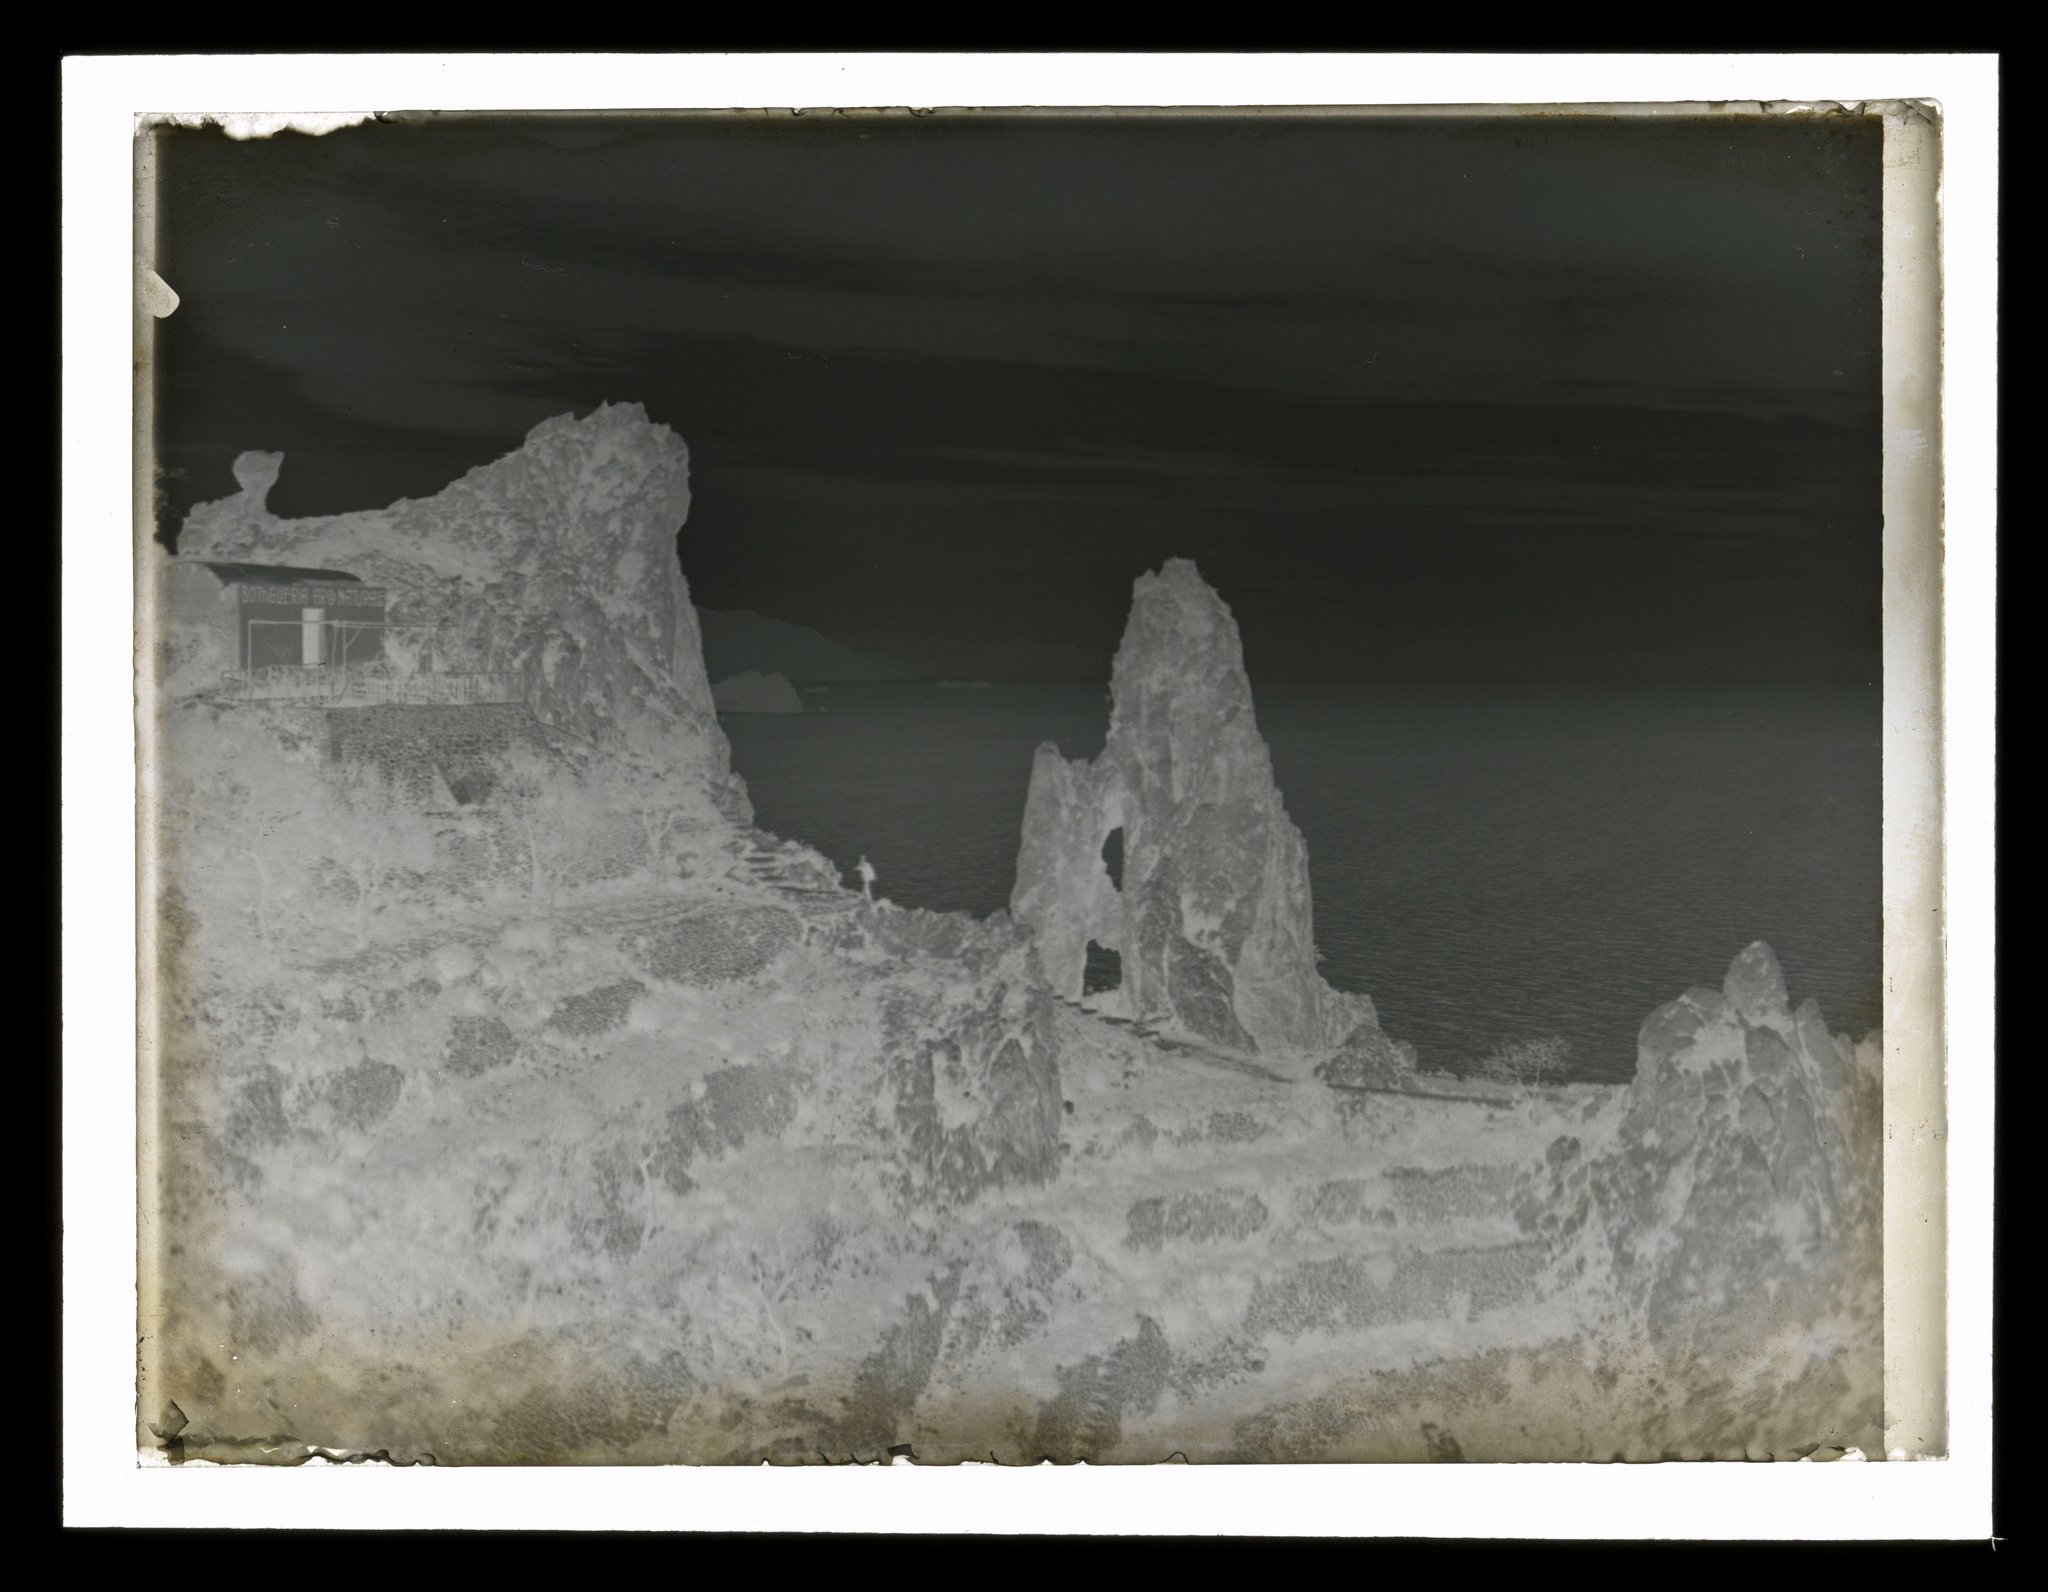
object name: photograph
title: Gebouw in landschap met rotsen, Sorrento of Capri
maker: Anonymous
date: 1907-1935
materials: glass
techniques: gelatin glass negative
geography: campania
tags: farm or solitary house in landscape, rocks, campania